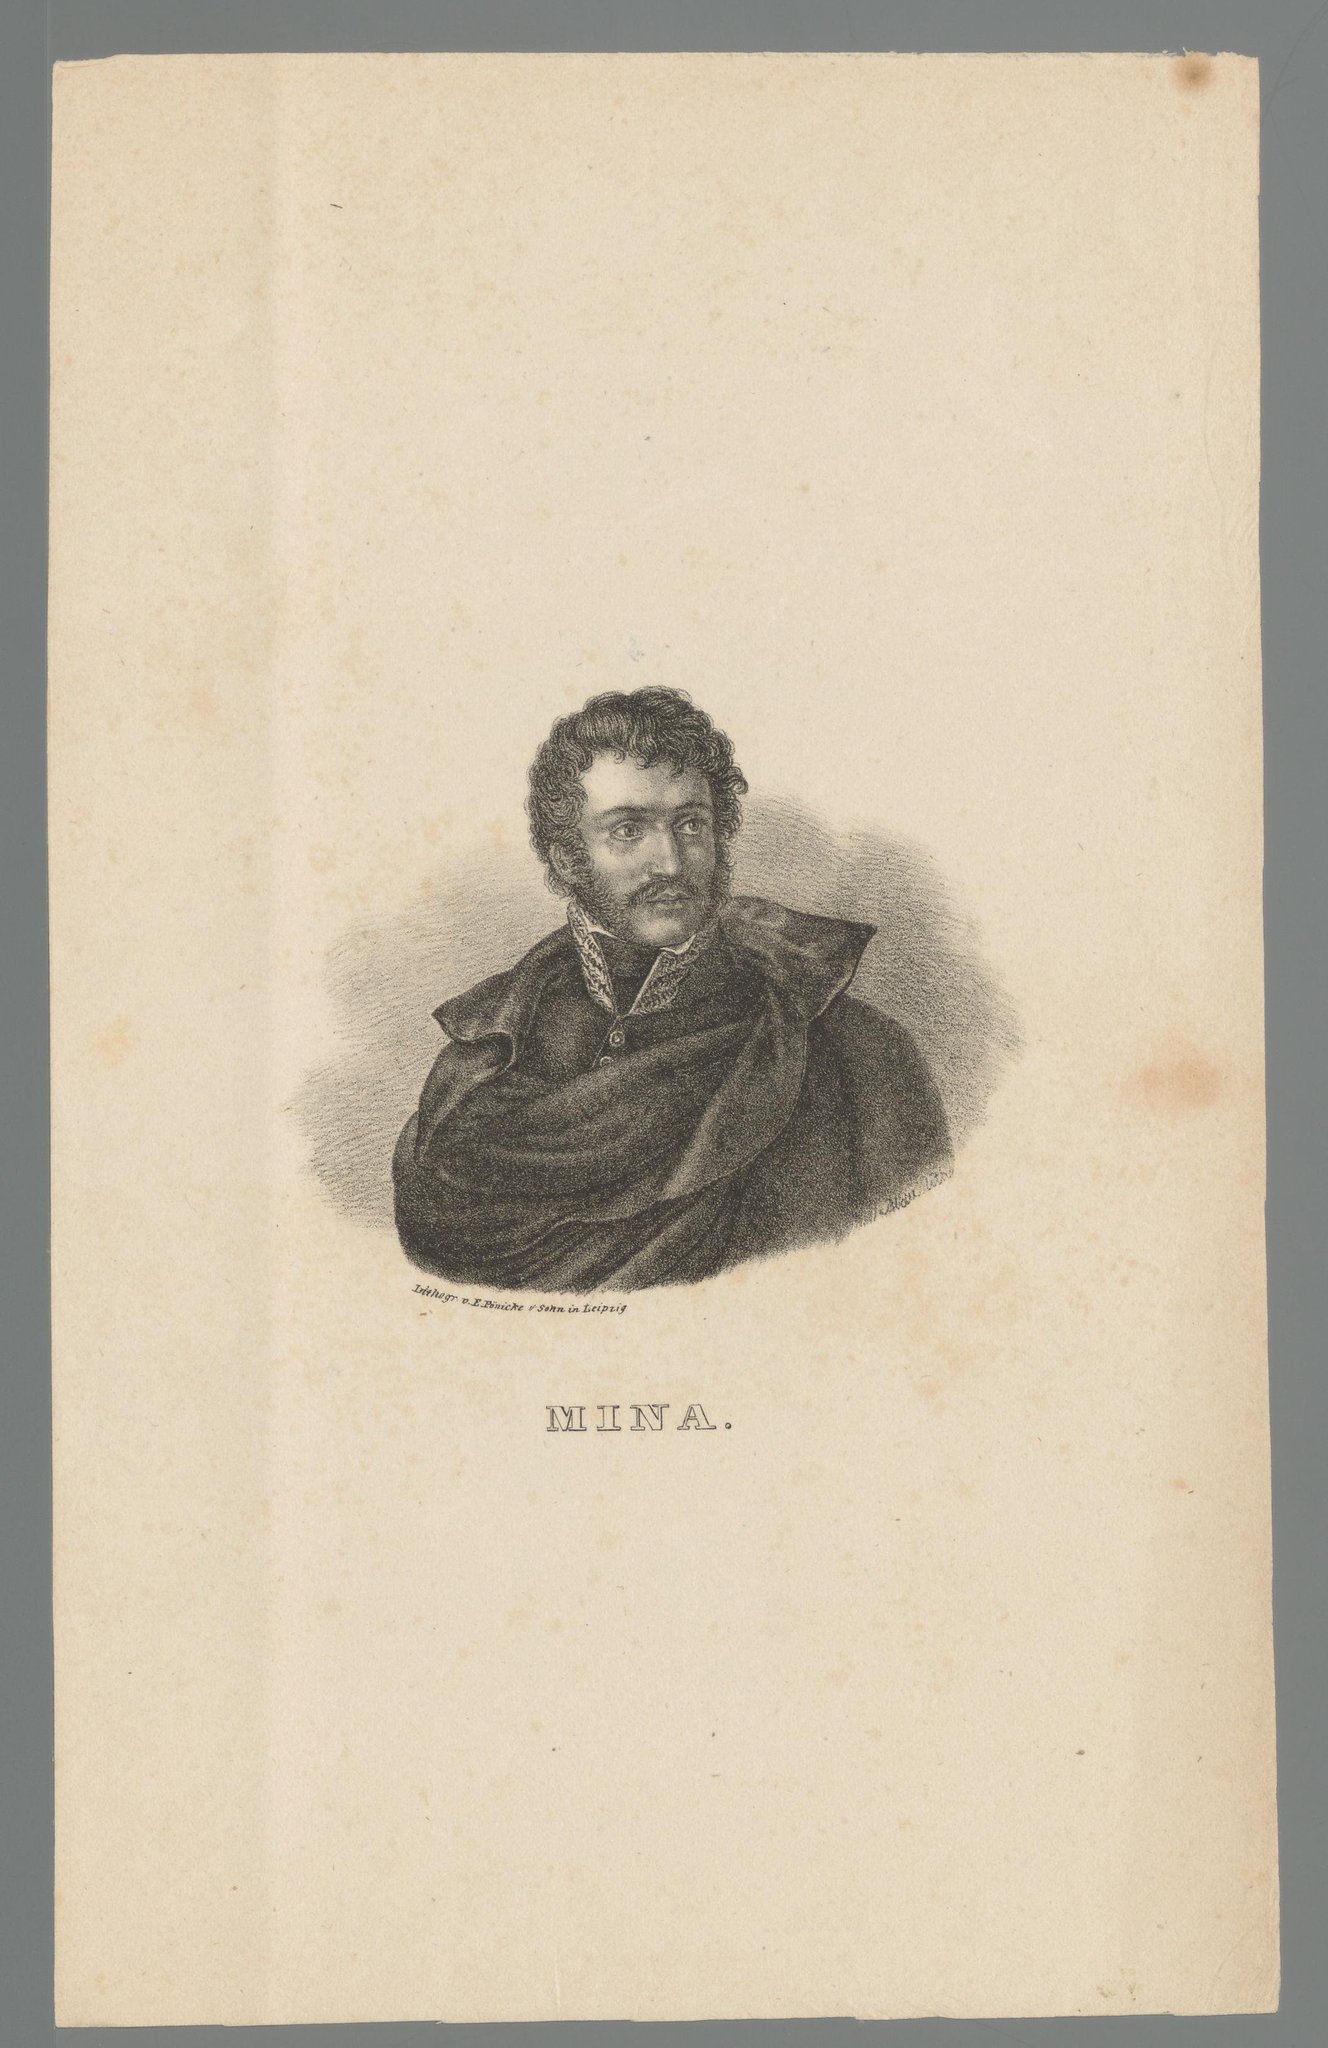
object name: print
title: Mina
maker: ludwig blau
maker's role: print maker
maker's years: 1808-1899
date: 1840-1899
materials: paper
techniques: lithograph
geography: leipzig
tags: adult man, historical persons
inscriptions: collector's mark: Lugt 2228